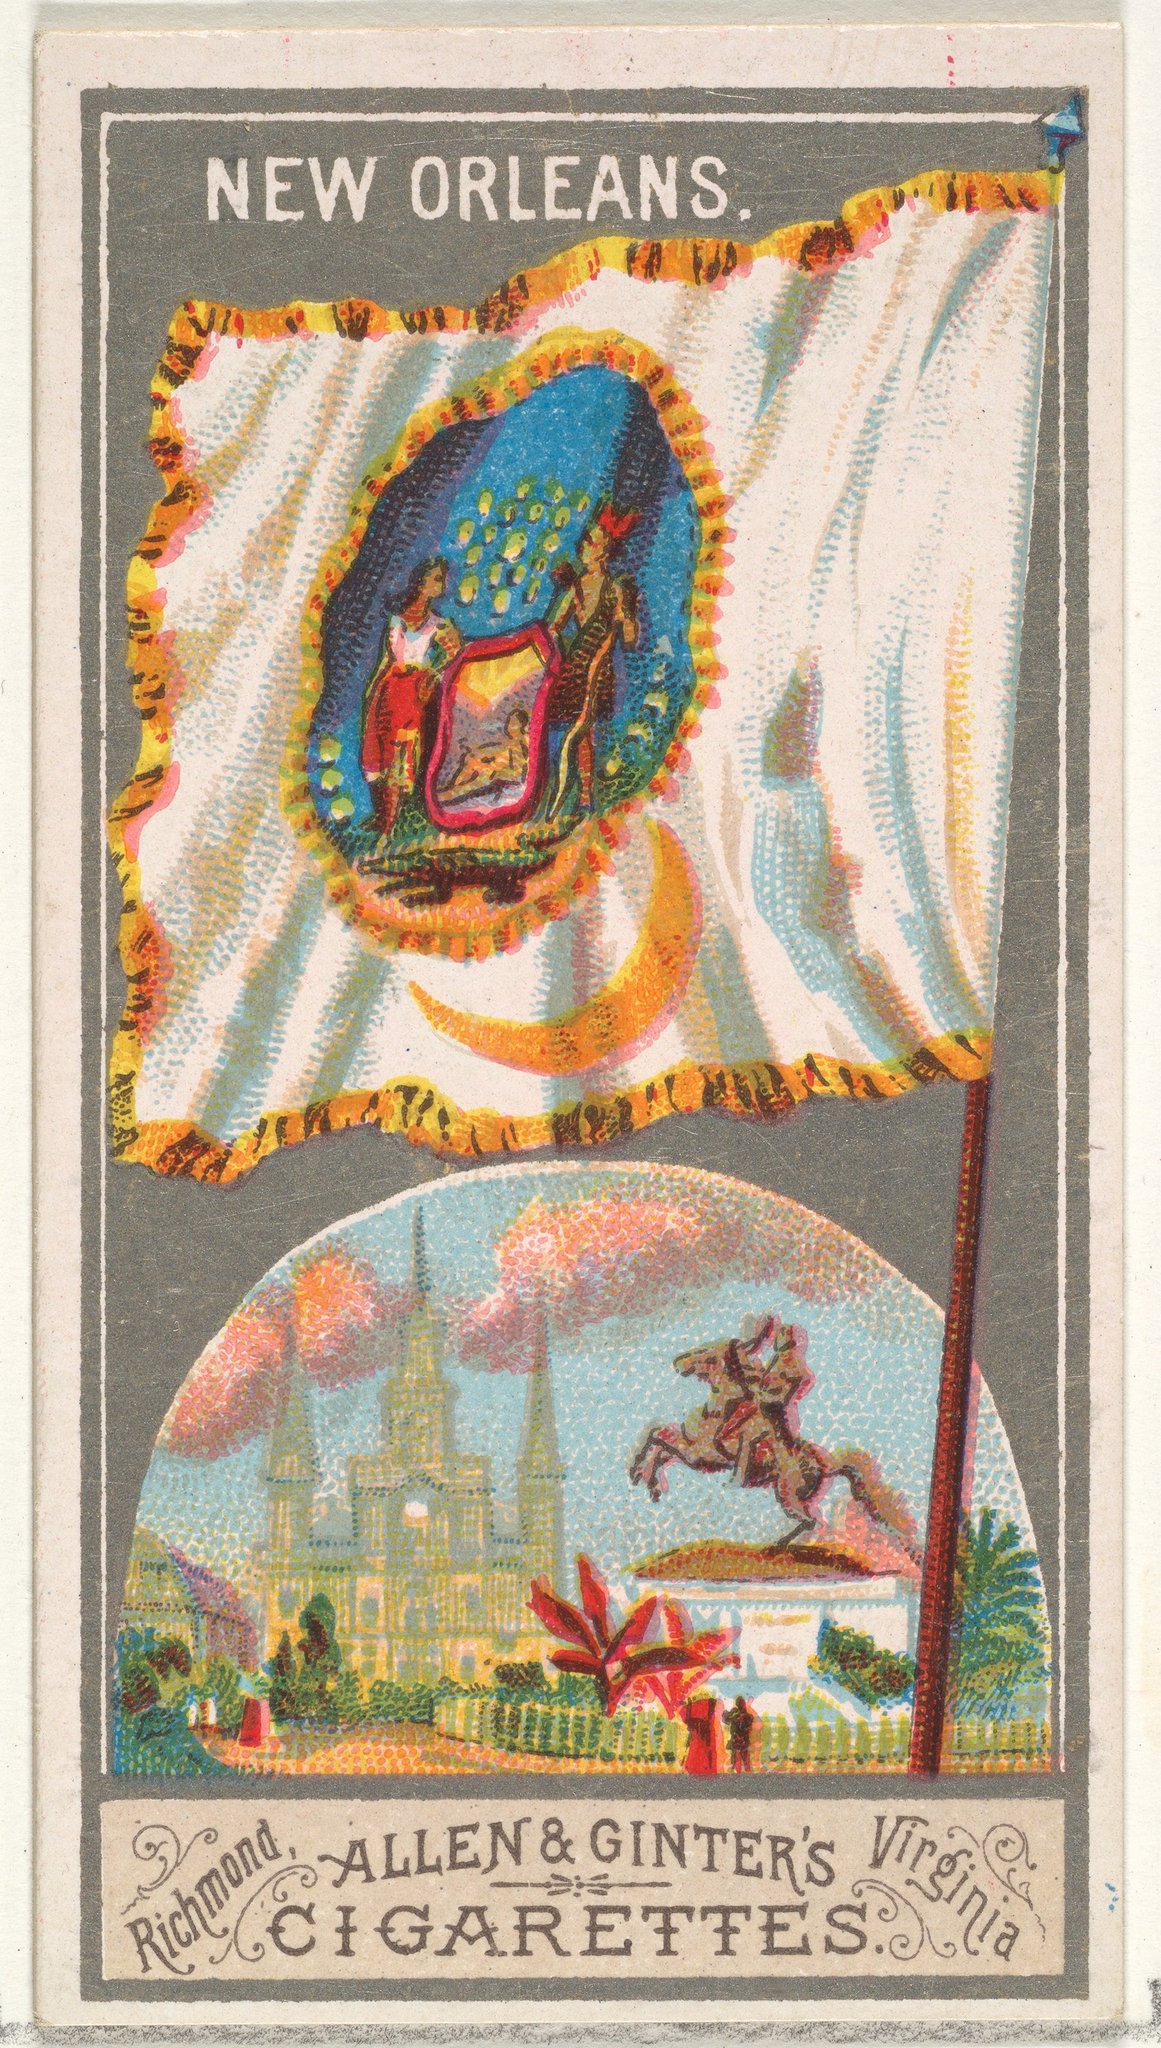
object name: print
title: New Orleans, from the City Flags series (N6) for Allen & Ginter Cigarettes Brands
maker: allen & ginter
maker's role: publisher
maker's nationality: american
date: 1887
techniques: color lithograph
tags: flags